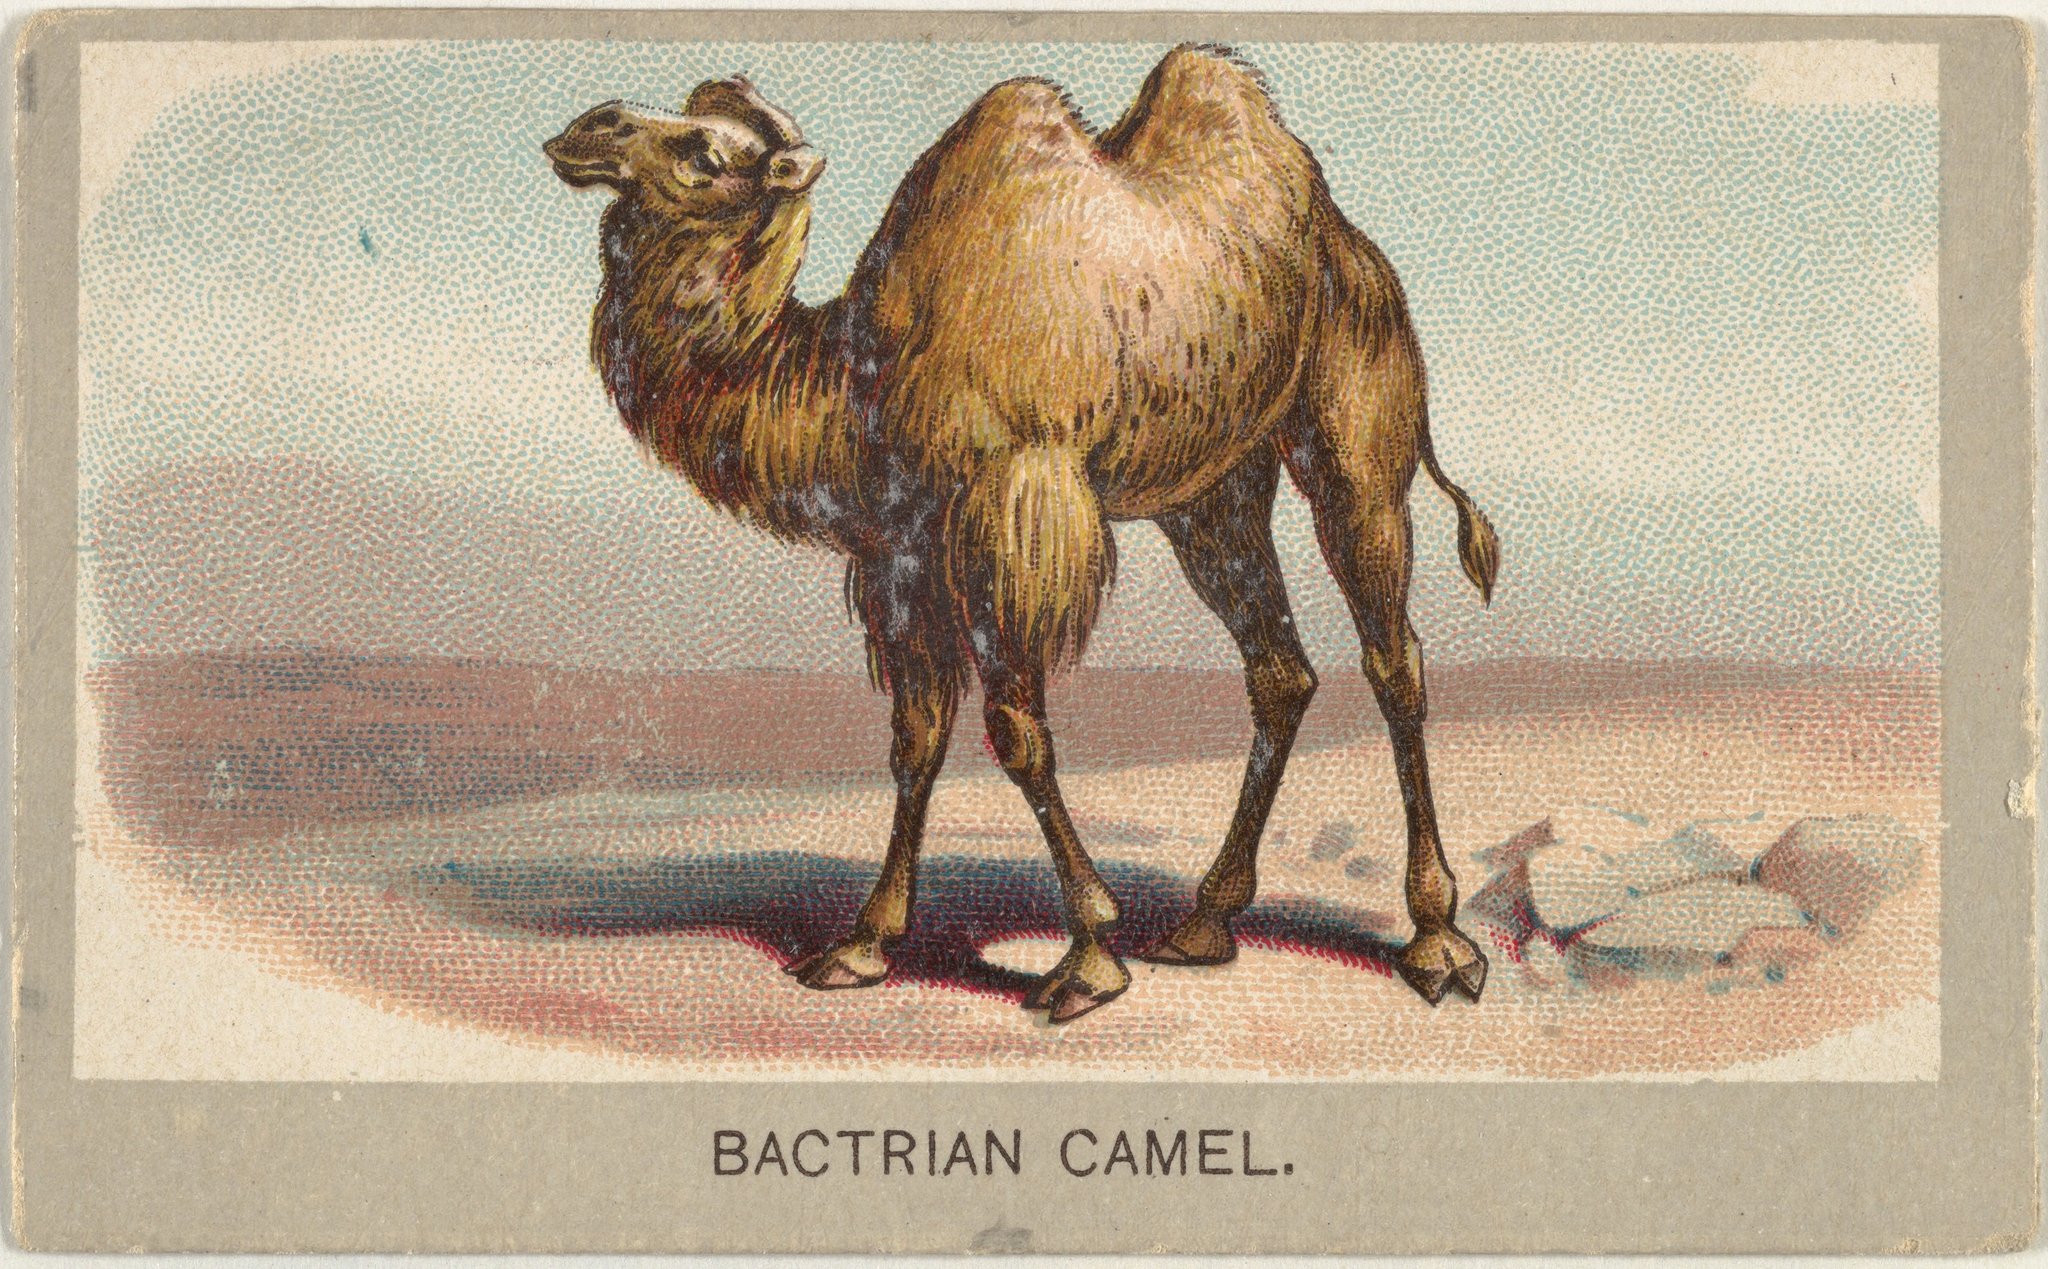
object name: print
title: Bactrian Camel, from the Animals of the World series (T180), issued by Abdul Cigarettes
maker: abdul cigarettes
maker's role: publisher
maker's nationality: american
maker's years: 1881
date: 1881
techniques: color lithograph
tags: camels